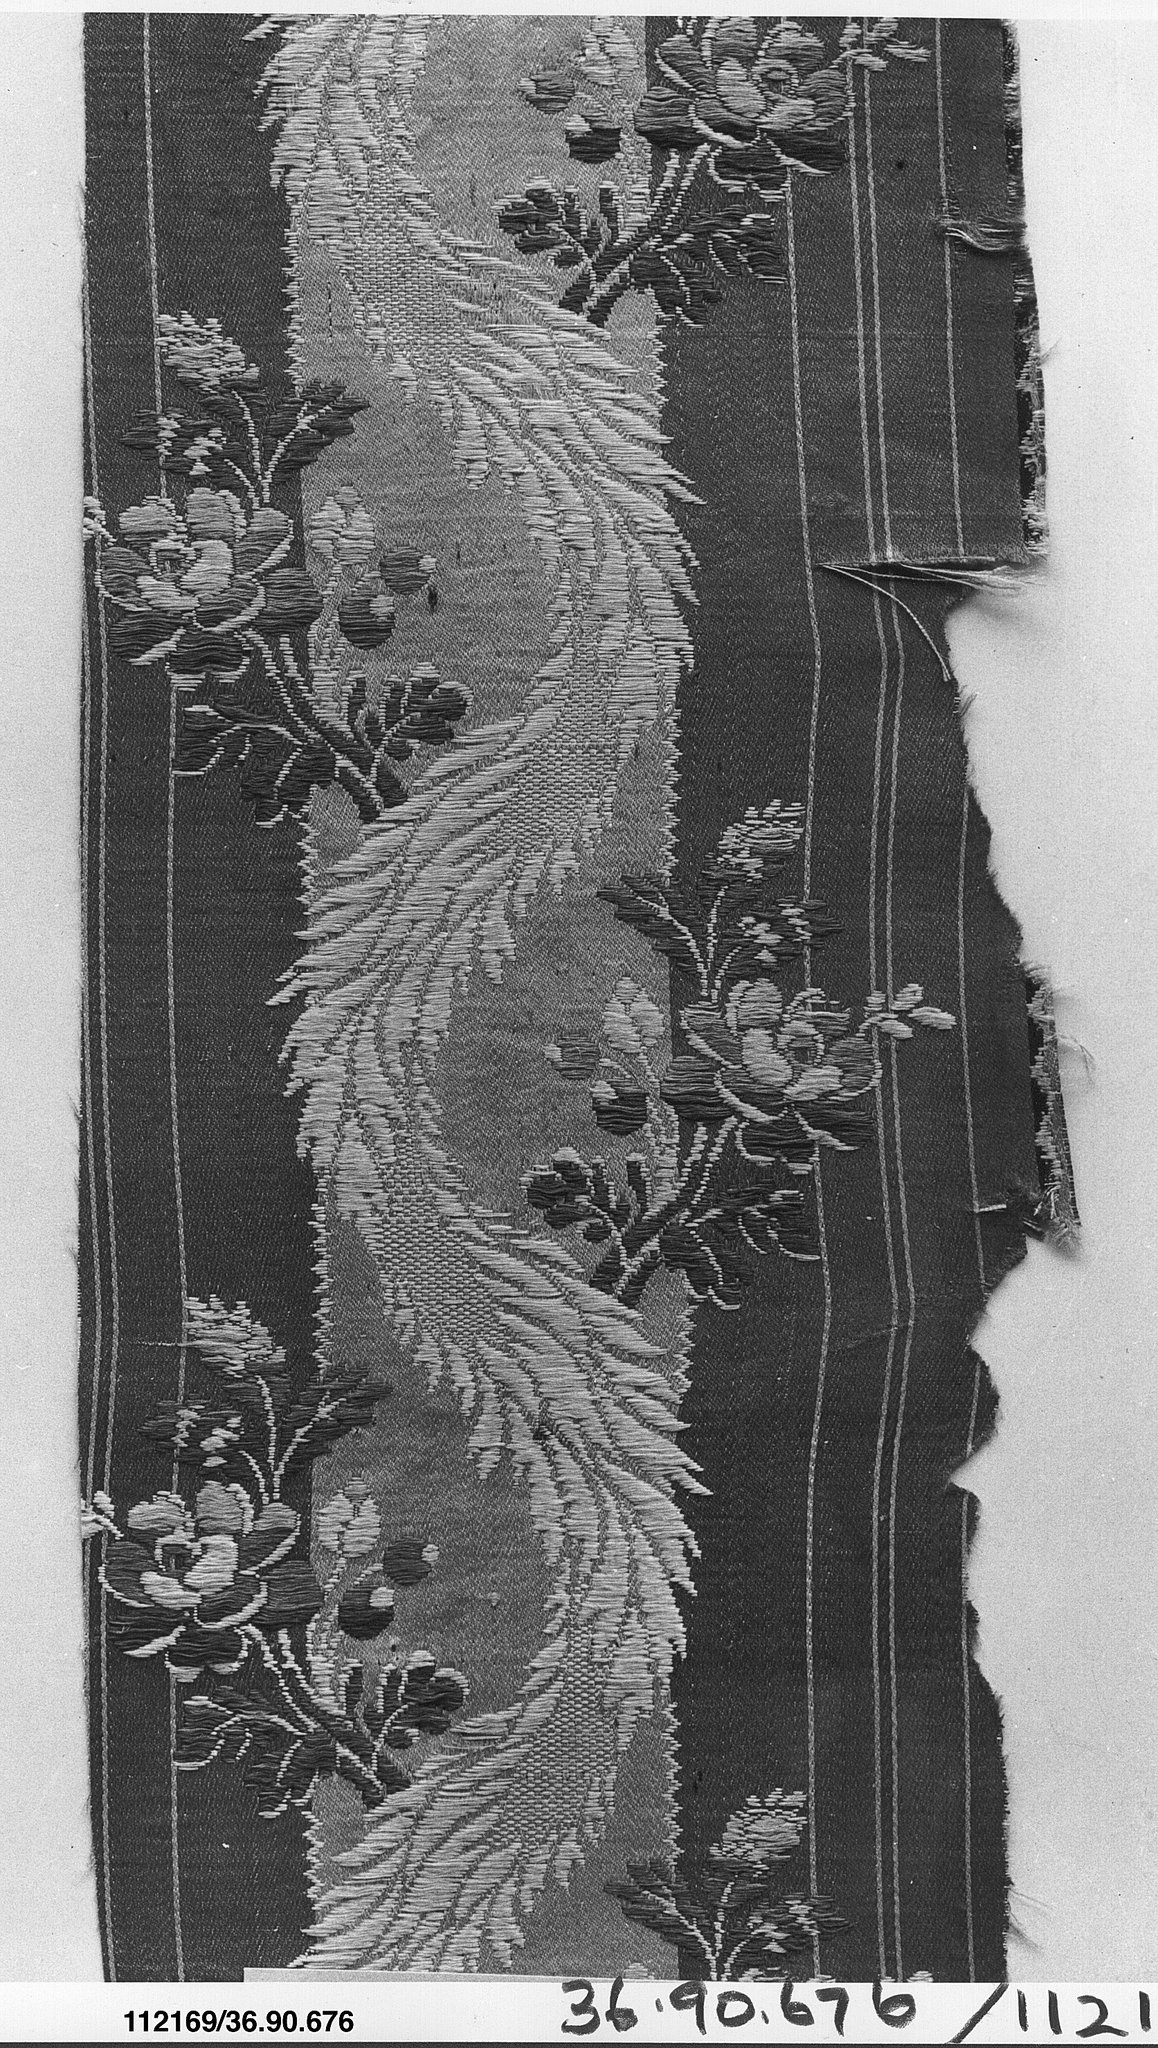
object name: piece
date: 1760-1770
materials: silk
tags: flowers,leaves